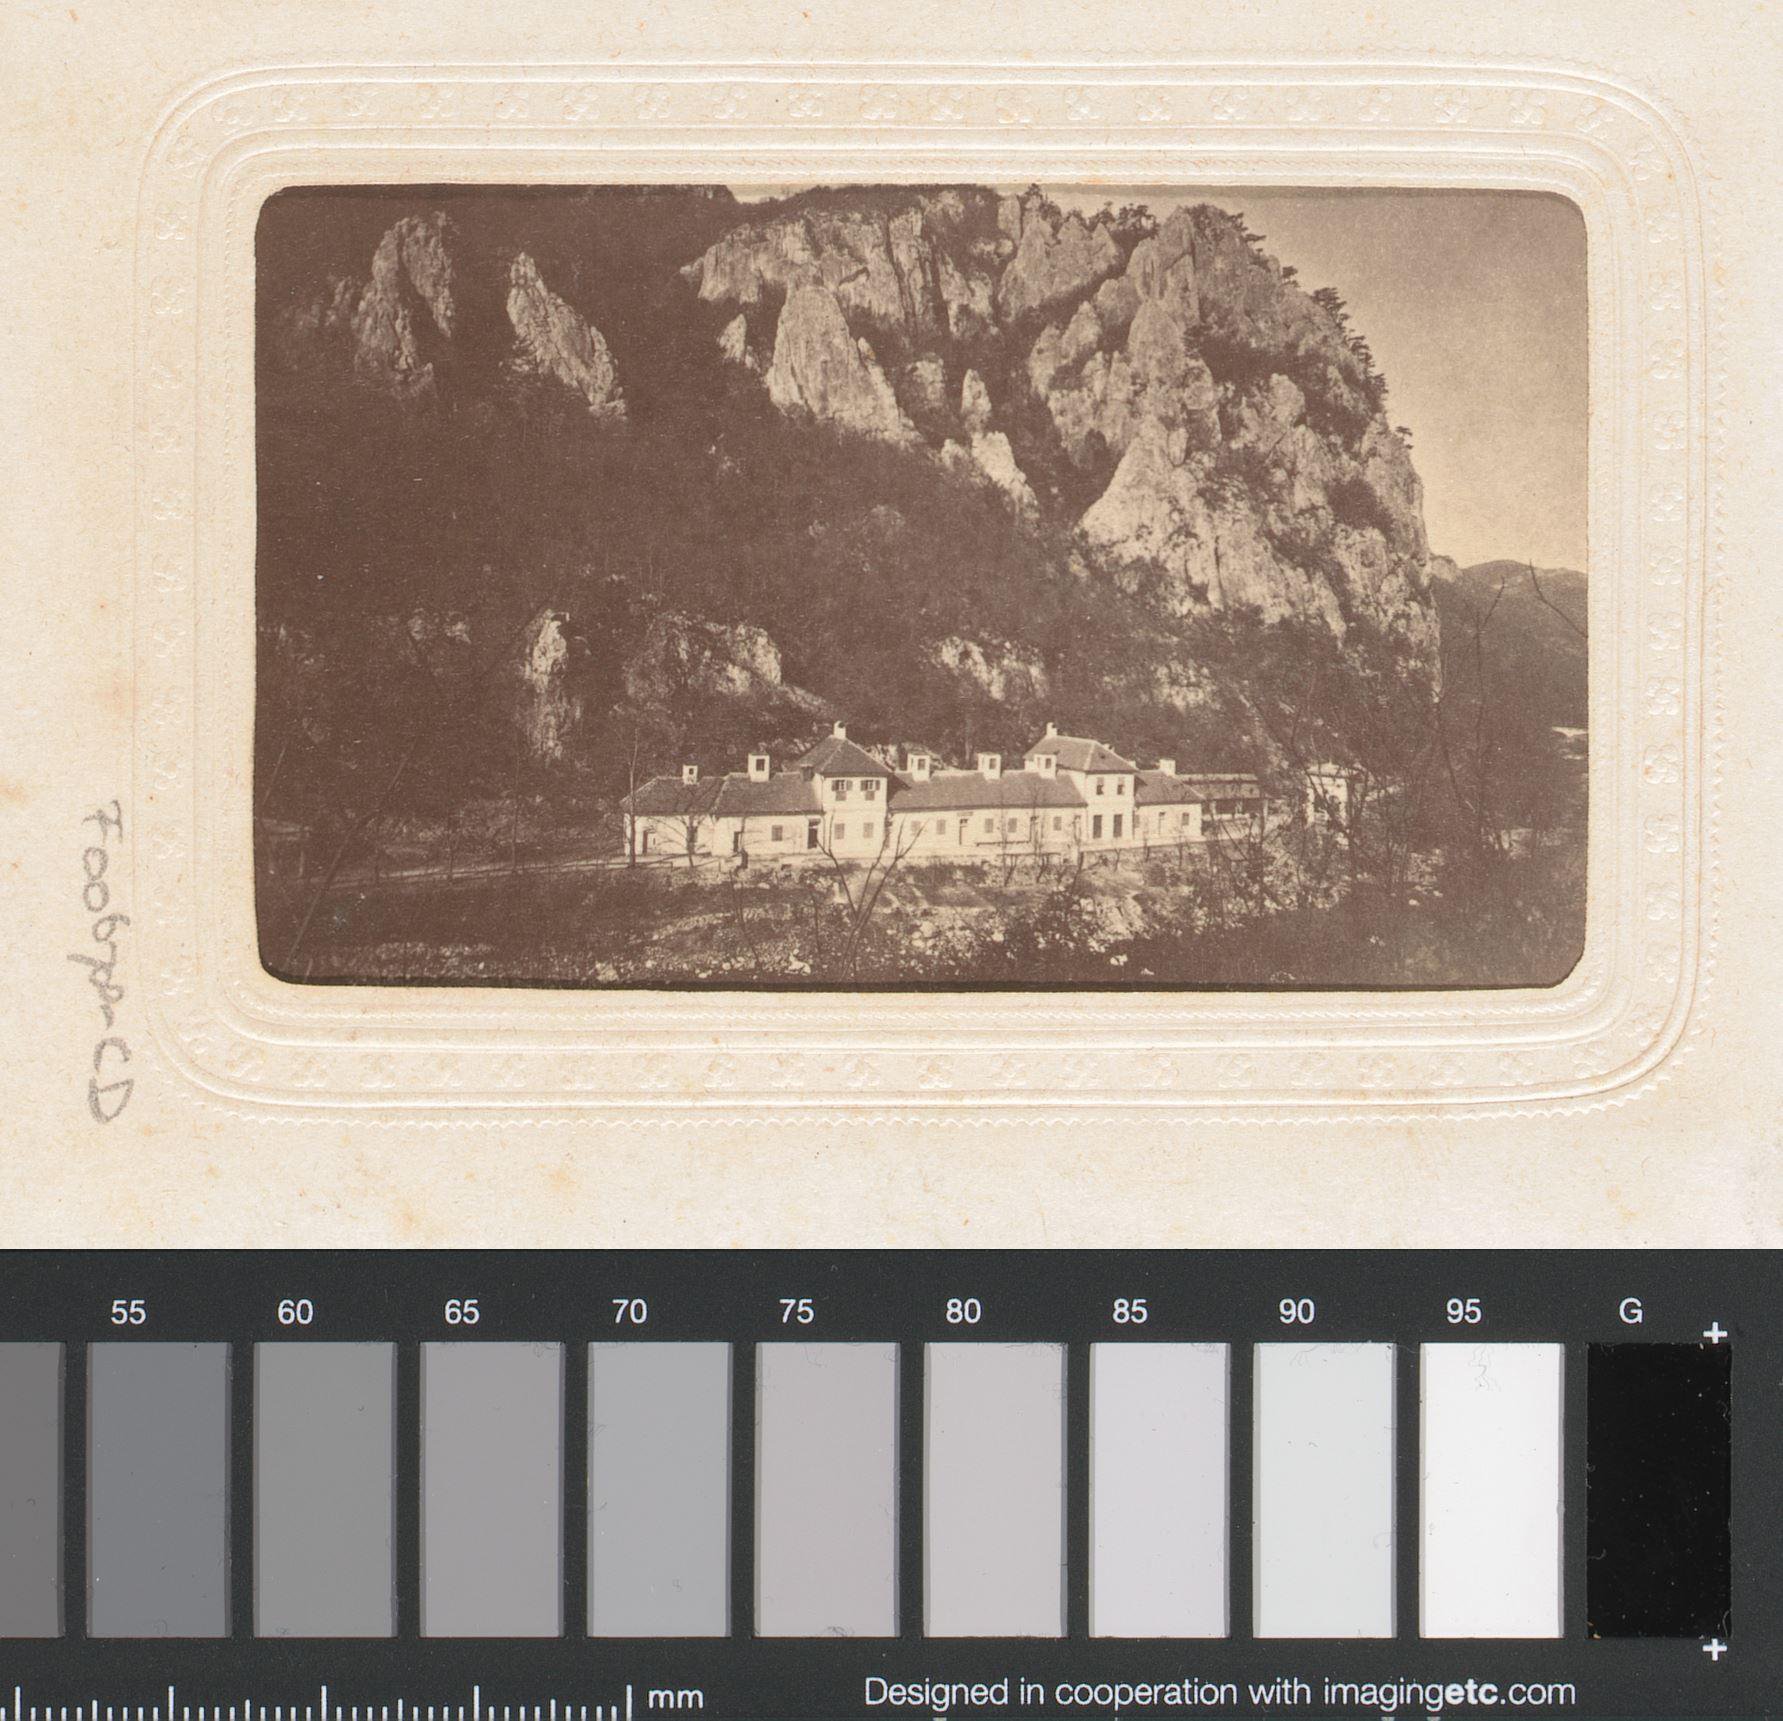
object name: carte de visite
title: Gezicht op Băile Herculane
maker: Anonymous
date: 1860-1880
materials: cardboard, photographic support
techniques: albumen print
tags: city-view in general; 'veduta', mountains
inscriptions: annotation: ‘Hercules Baad’, annotation: ‘Uchadia’, inscription: ‘Herculesbad./ Aufgenommen von Carl Händl,/ Photograph’